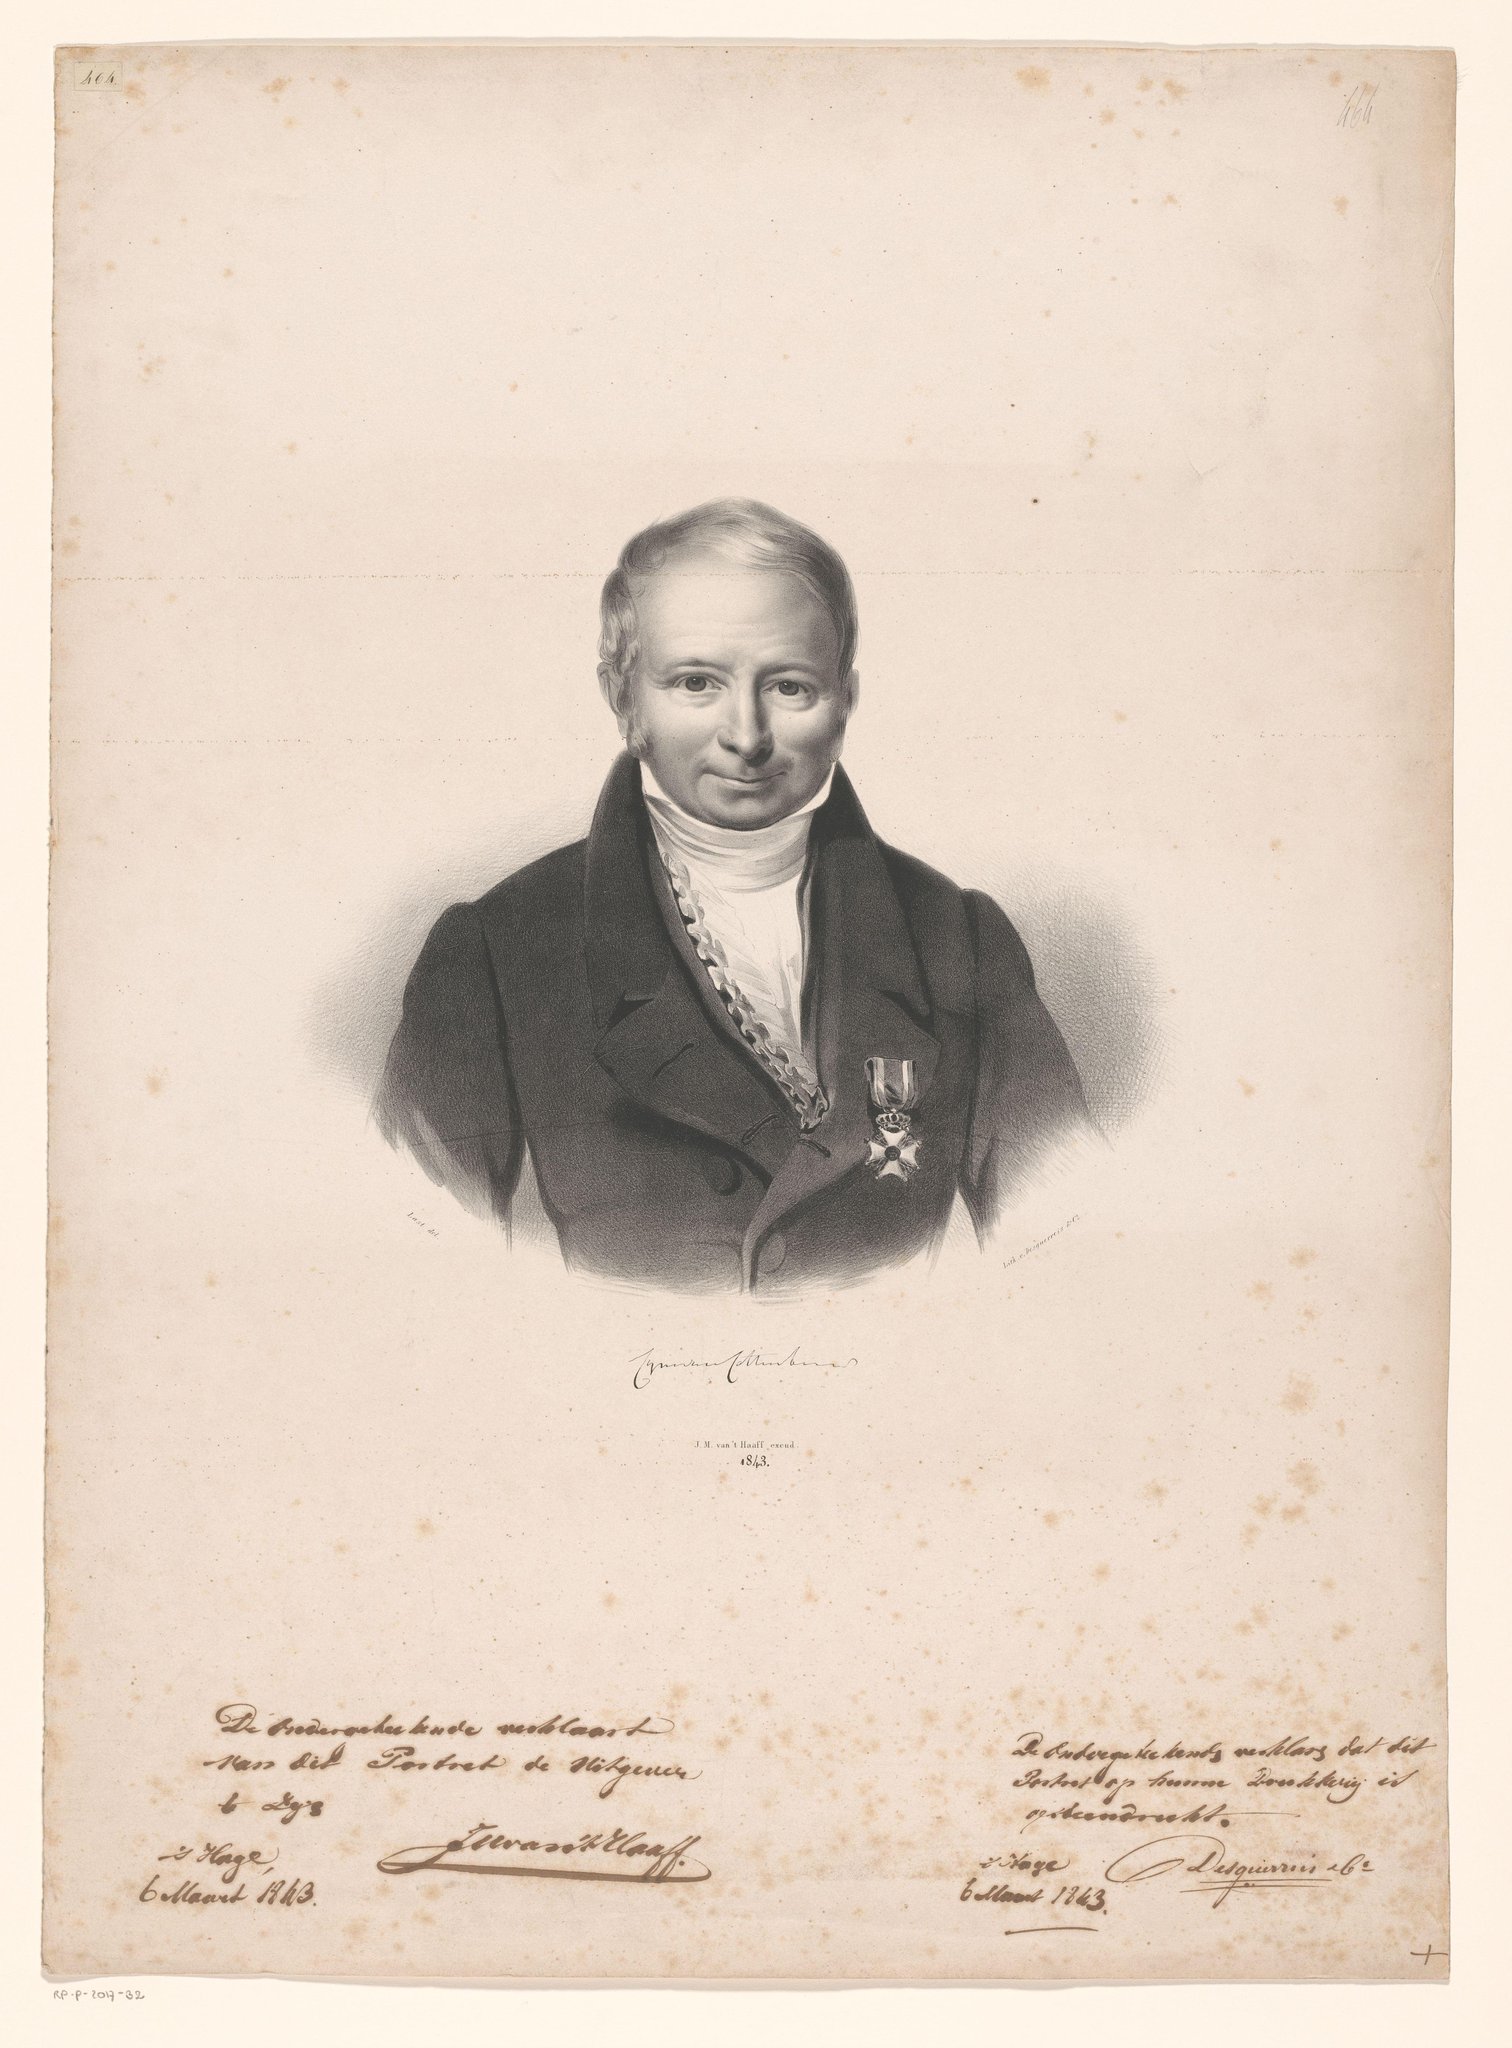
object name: print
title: Portret van Lodewijk Constantijn Rabo Copes van Cattenburch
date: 1843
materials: paper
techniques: lithograph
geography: the hague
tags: mayor, historical persons (+ (full) bust portrait)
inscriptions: : ‘De ondergeteekende verklaart dat dit / portret op hunne drukkerij is gesteendrukt. / Desguerrois e Co / 's Hage / 6 Maart 1843’, : ‘De ondergeteekende verklaart / van dit portret de uitgever / te zijn / 's Hage, /J.M. van 't Haaf / 6 maart 1843’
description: Onder het portret de signatuur van de geportretteerde.